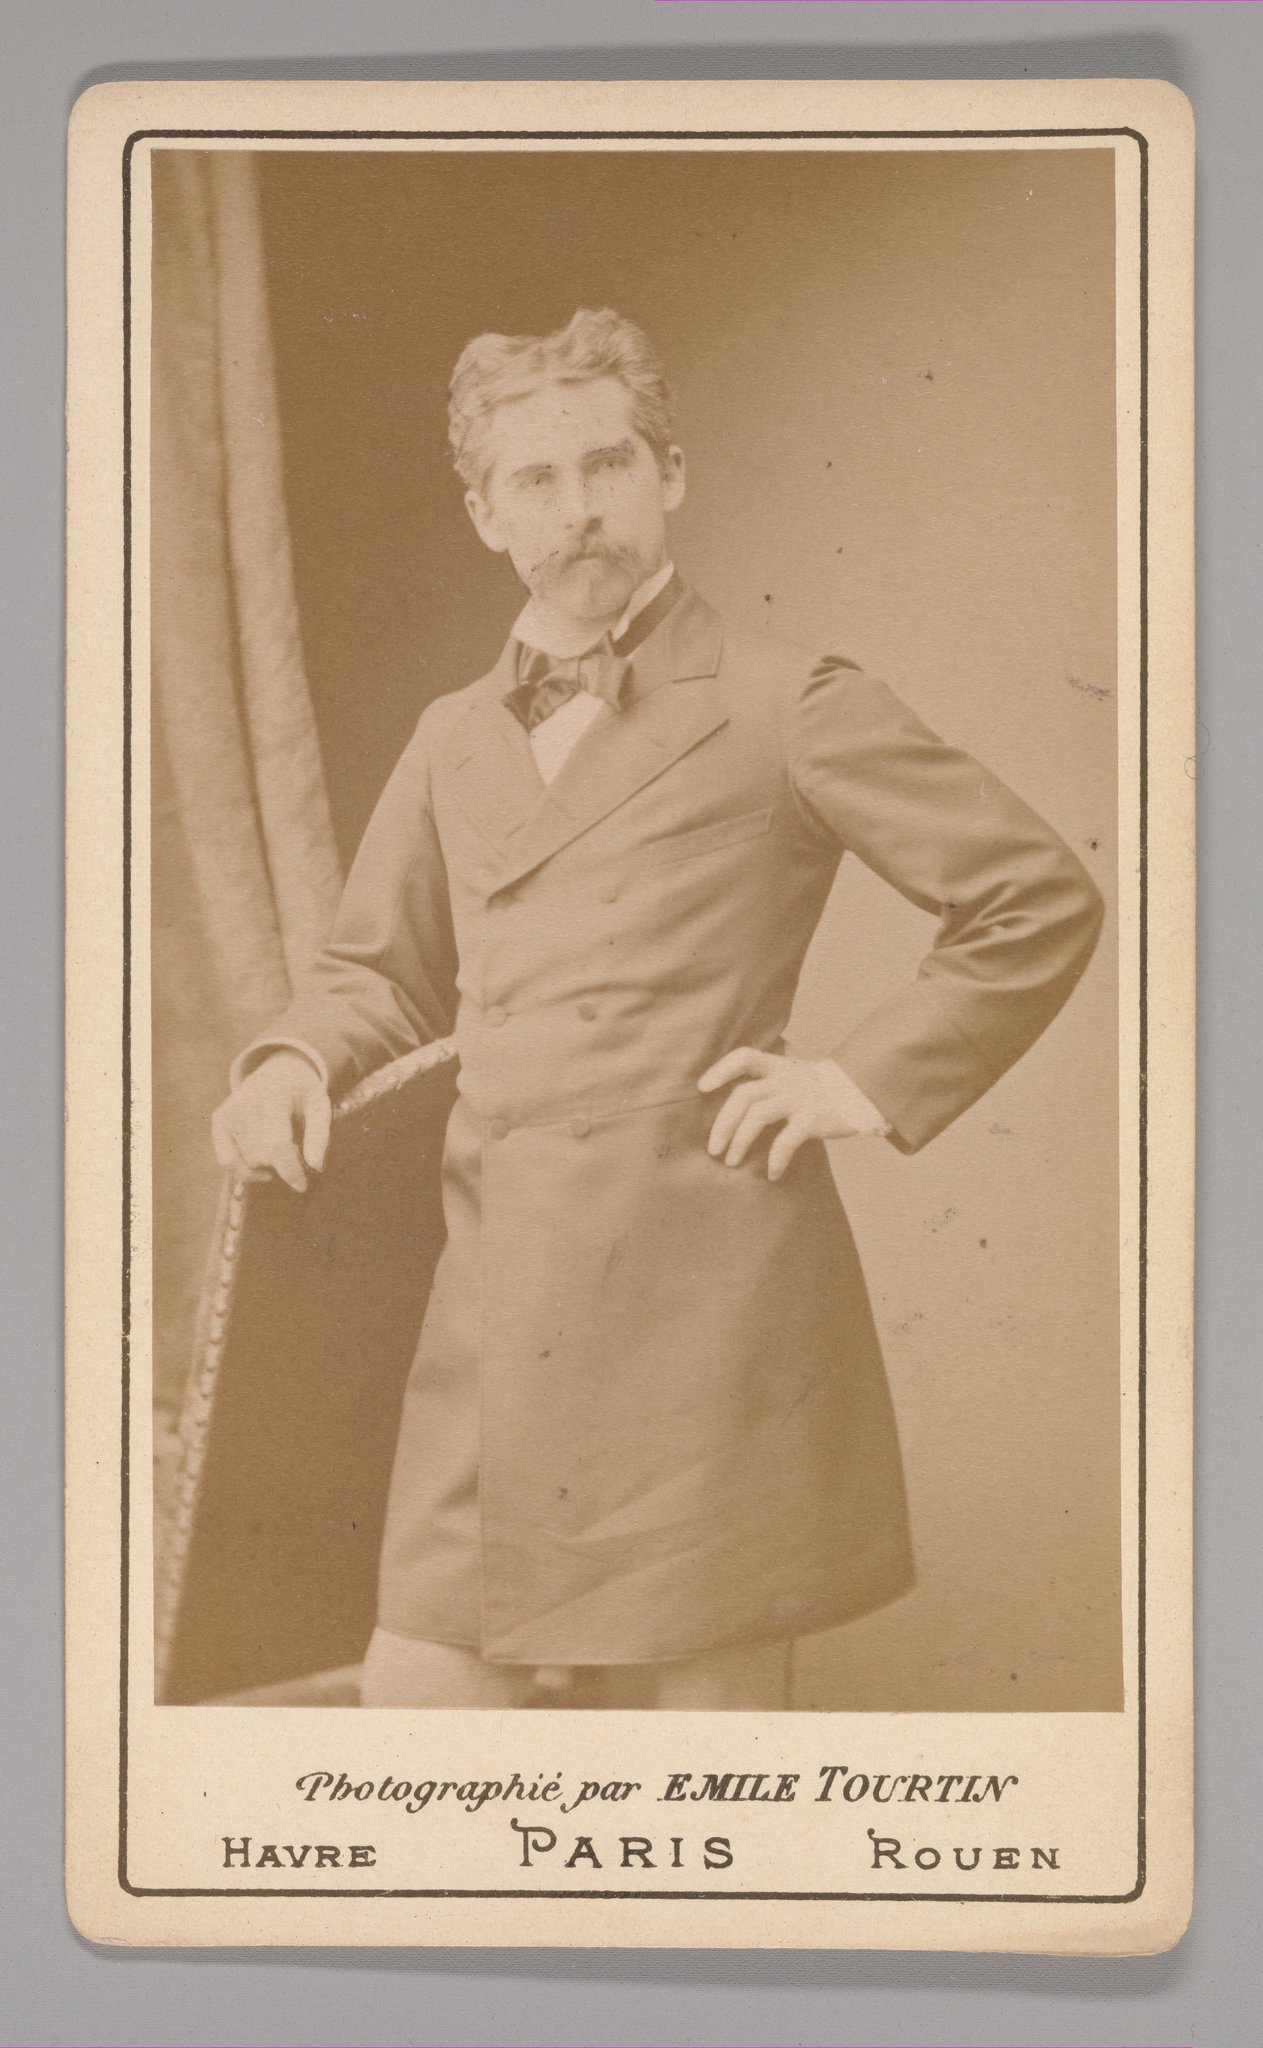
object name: carte de visite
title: [Unknown Subject]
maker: emile tourtin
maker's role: artist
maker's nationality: french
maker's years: 1860-1880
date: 1860-1869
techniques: albumen silver print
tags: men,portraits